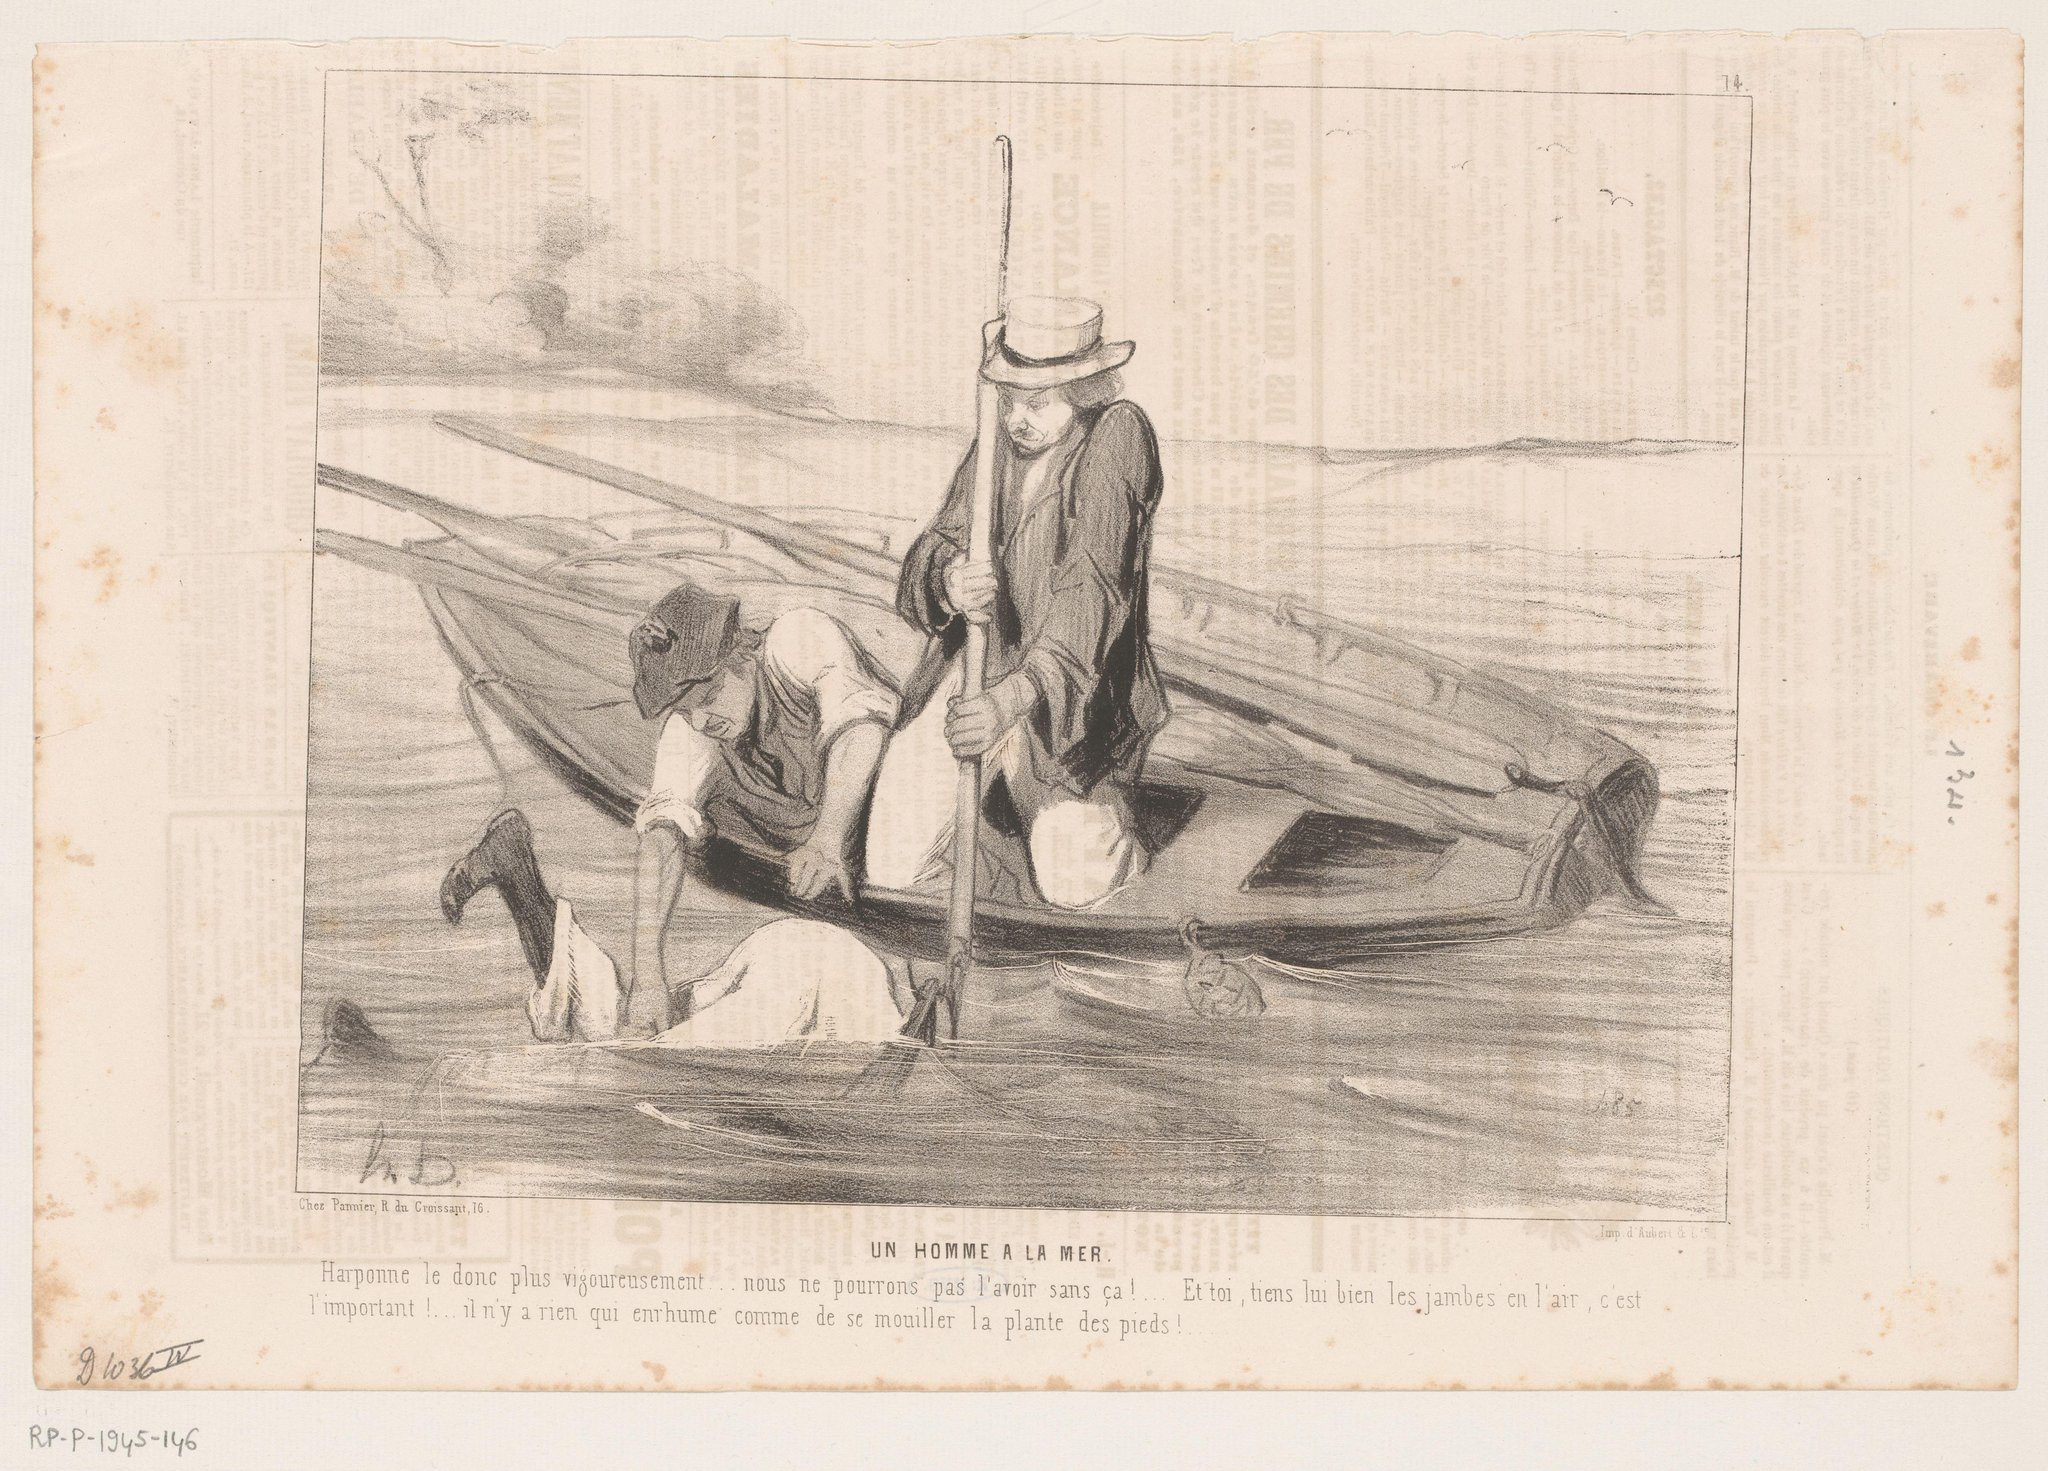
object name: cartoon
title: Parijse schippers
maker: honoré daumier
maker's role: draughtsman, painter, print maker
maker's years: 1808-1879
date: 1843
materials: paper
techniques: lithograph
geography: paris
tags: caricatures (human types), river, rowing-boat, canoe, etc., saving a person from drowning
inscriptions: number: ‘134’, collector's mark: Lugt 2228a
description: Prent gepubliceerd in: Le Charivari, Aubert: Parijs, 11-06-1843. Le Charivari was een humoristische krant met karikaturen en (politieke) cartoons.